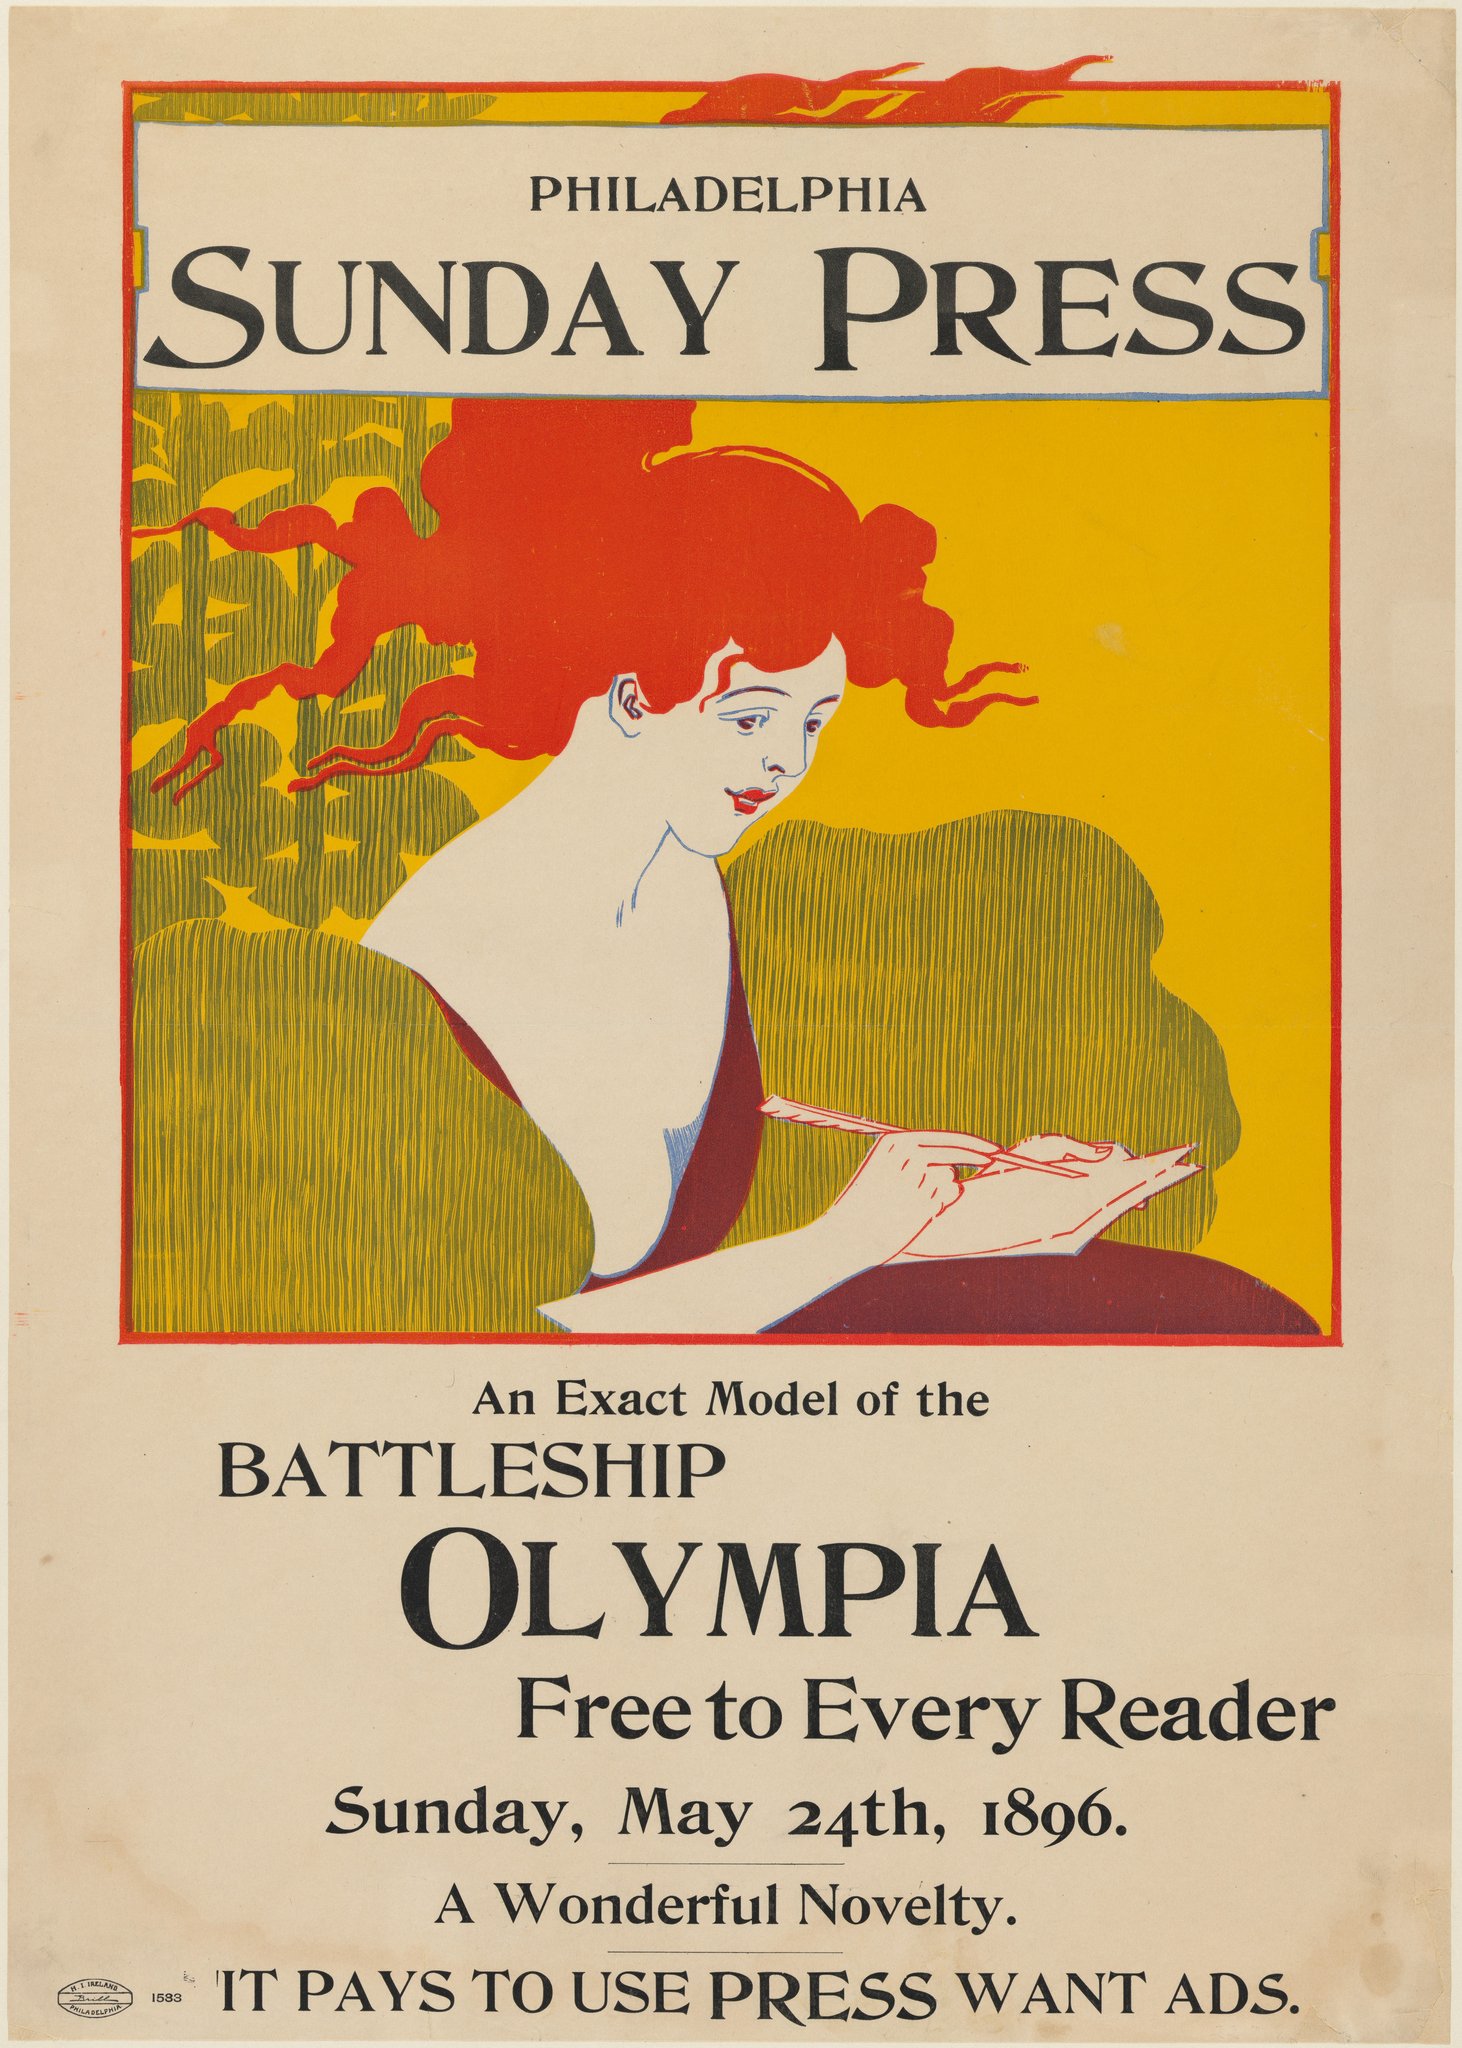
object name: print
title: Philadelphia Sunday Press, May 24th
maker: george reiter brill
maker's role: artist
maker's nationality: american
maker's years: 1867-1918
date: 1896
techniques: relief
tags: women,writing